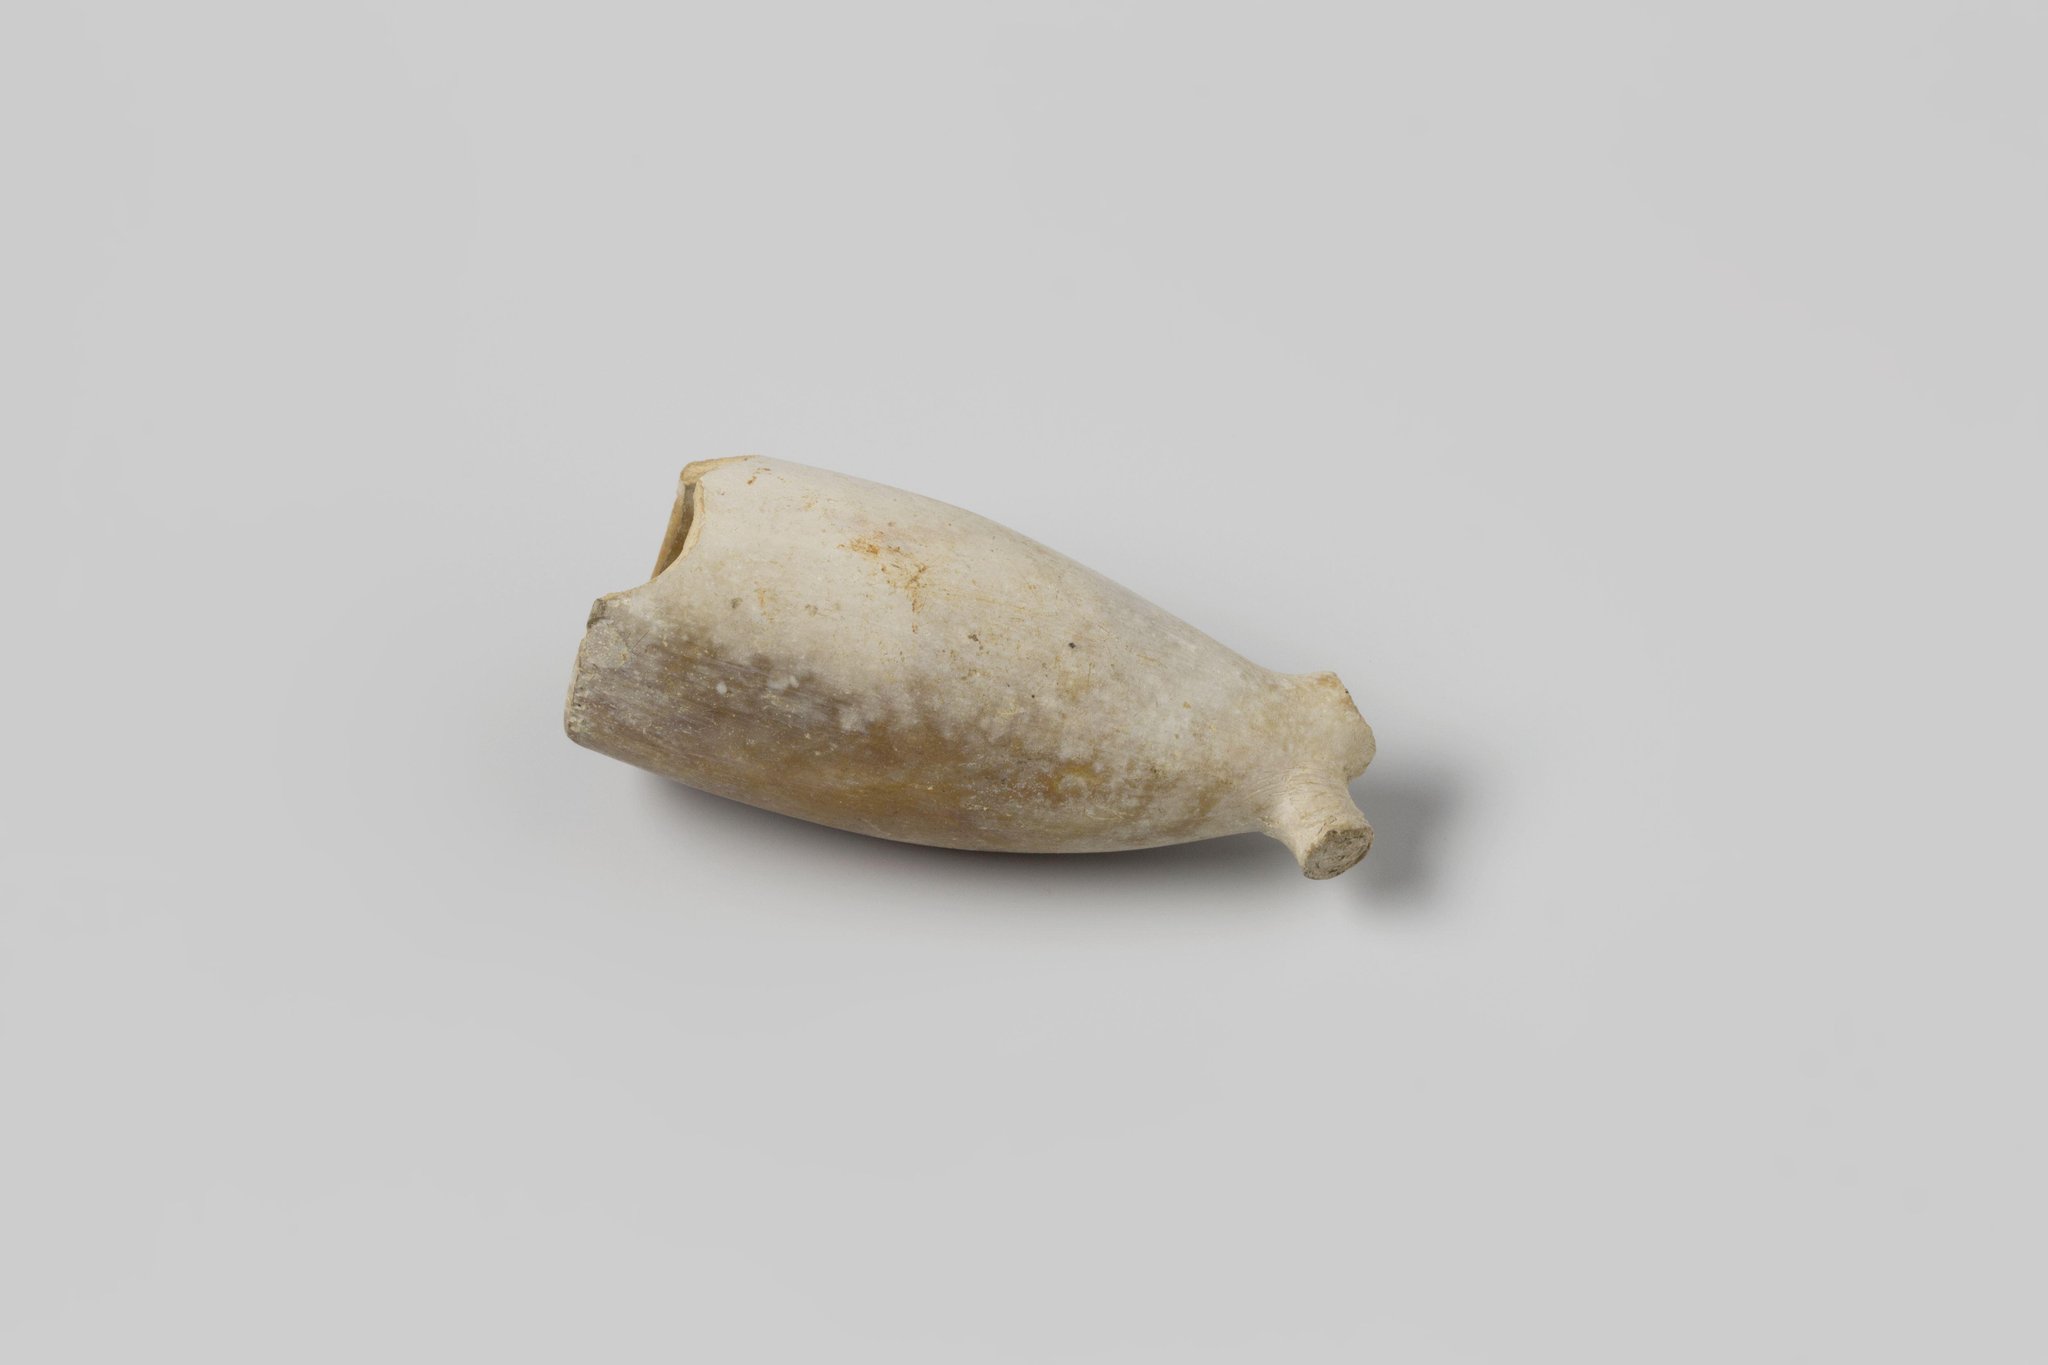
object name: pipe bowl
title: Pijpenkop uit het wrak van de Oost-Indiëvaarder Hollandia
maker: Anonymous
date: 1700-1743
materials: clay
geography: netherlands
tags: verenigde oostindische compagnie, hollandia (schip), annet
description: Pipe, bowl, heelmark: coat of arms of the province of Gelderland; fragm, no hsm.